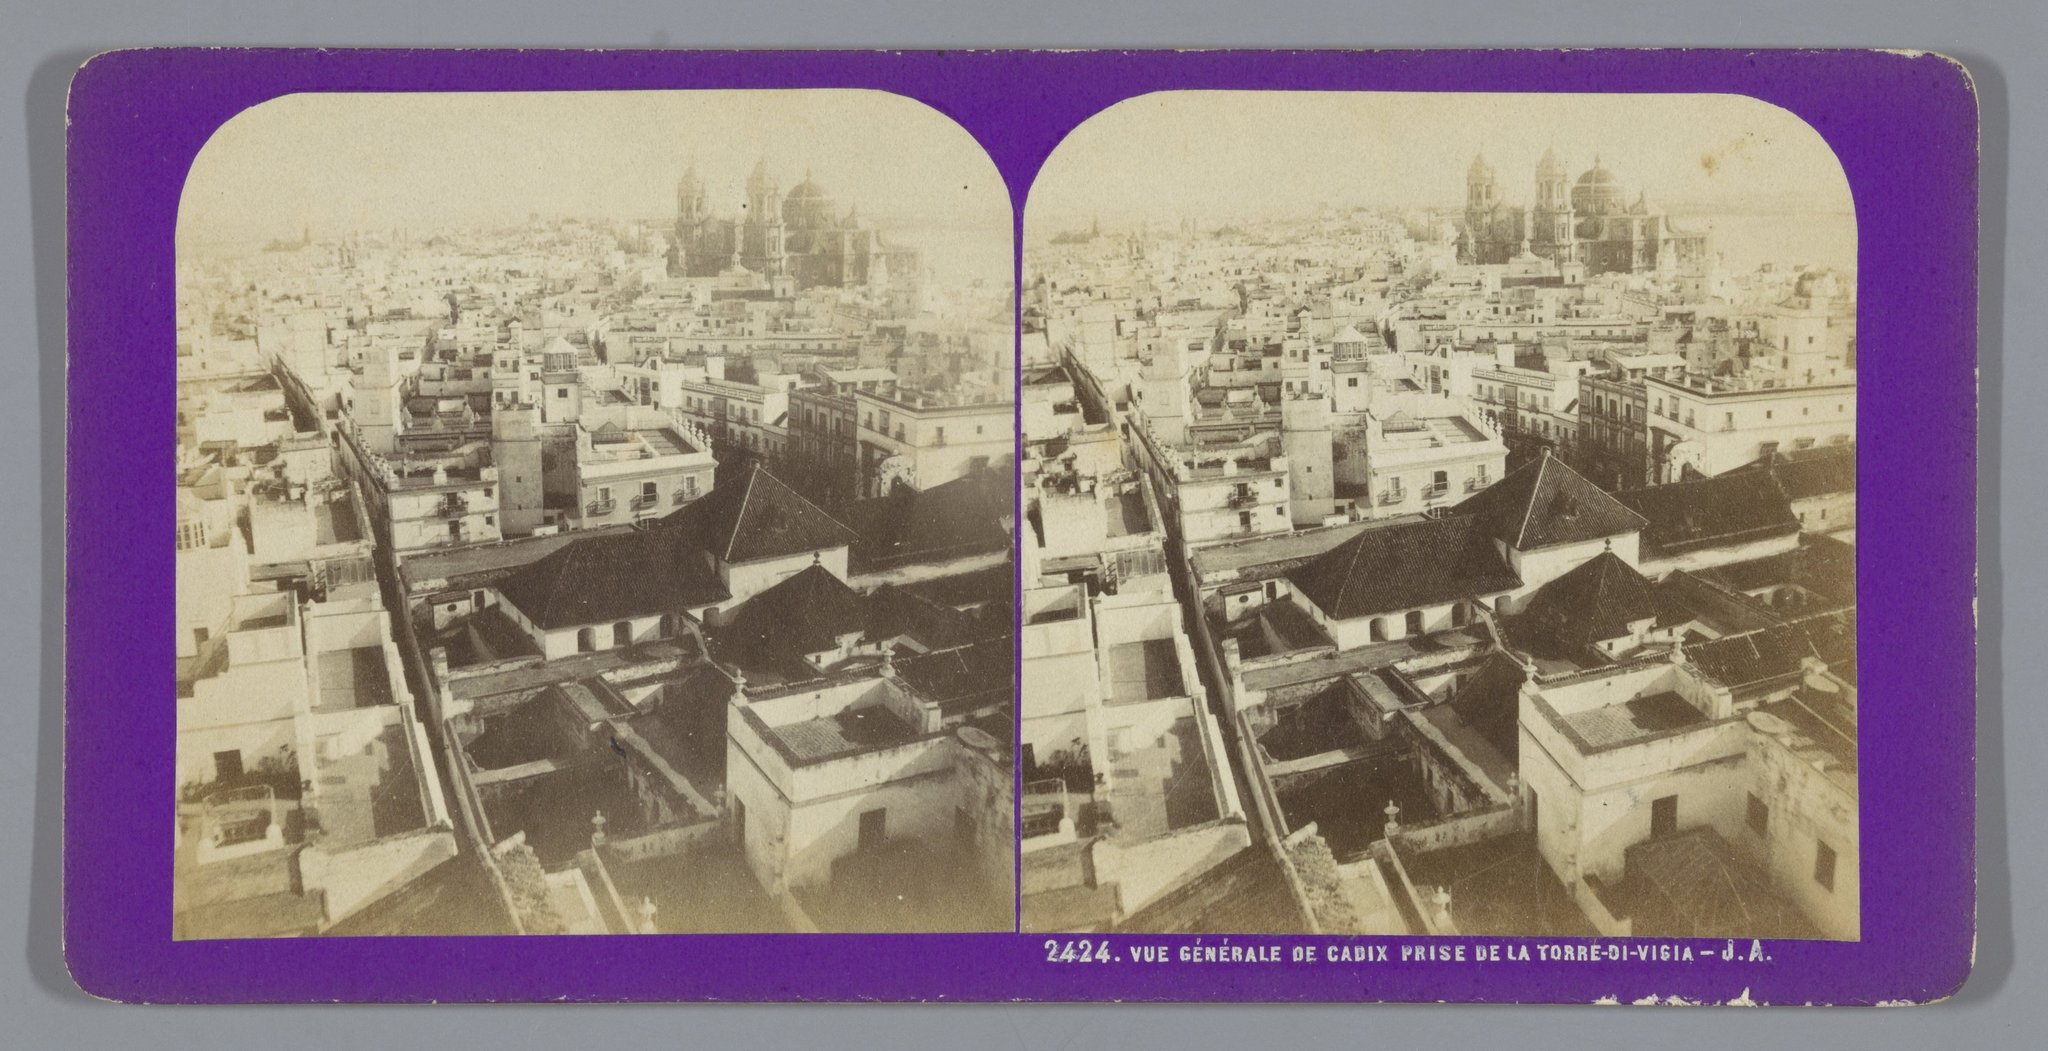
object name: stereograph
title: Vue générale de Cadix prise de la Torre-di-Vigia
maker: jean andrieu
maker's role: fotograaf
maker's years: 1816-1872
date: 1862-1876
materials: cardboard, photographic support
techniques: albumen print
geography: cádiz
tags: prospect of city, town panorama, silhouette of city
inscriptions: number: ‘2424.’